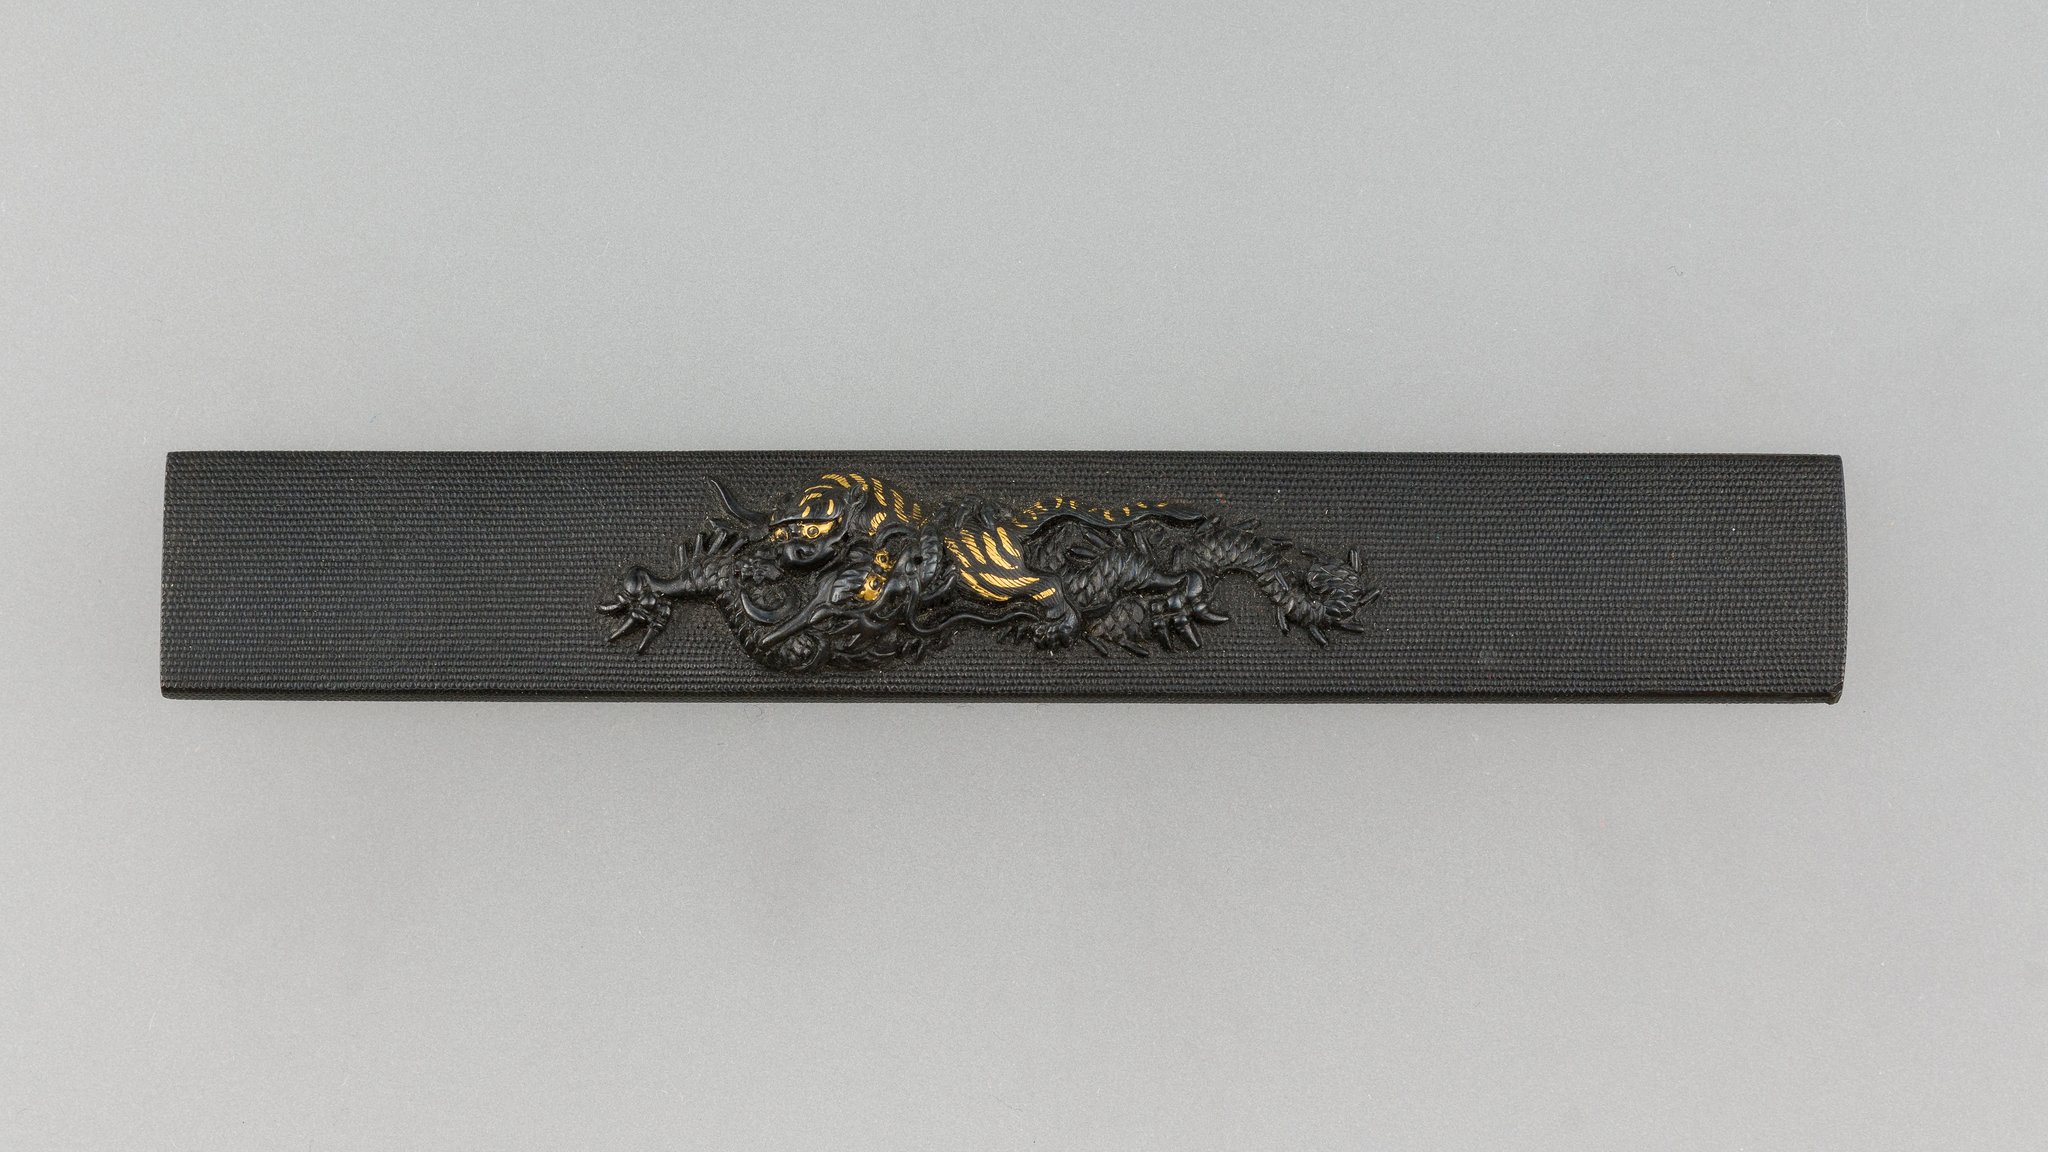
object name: knife handle kozuka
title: Knife Handle (Kozuka)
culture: japanese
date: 1701-1800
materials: gold alloy, gold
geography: japan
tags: dragons,tigers